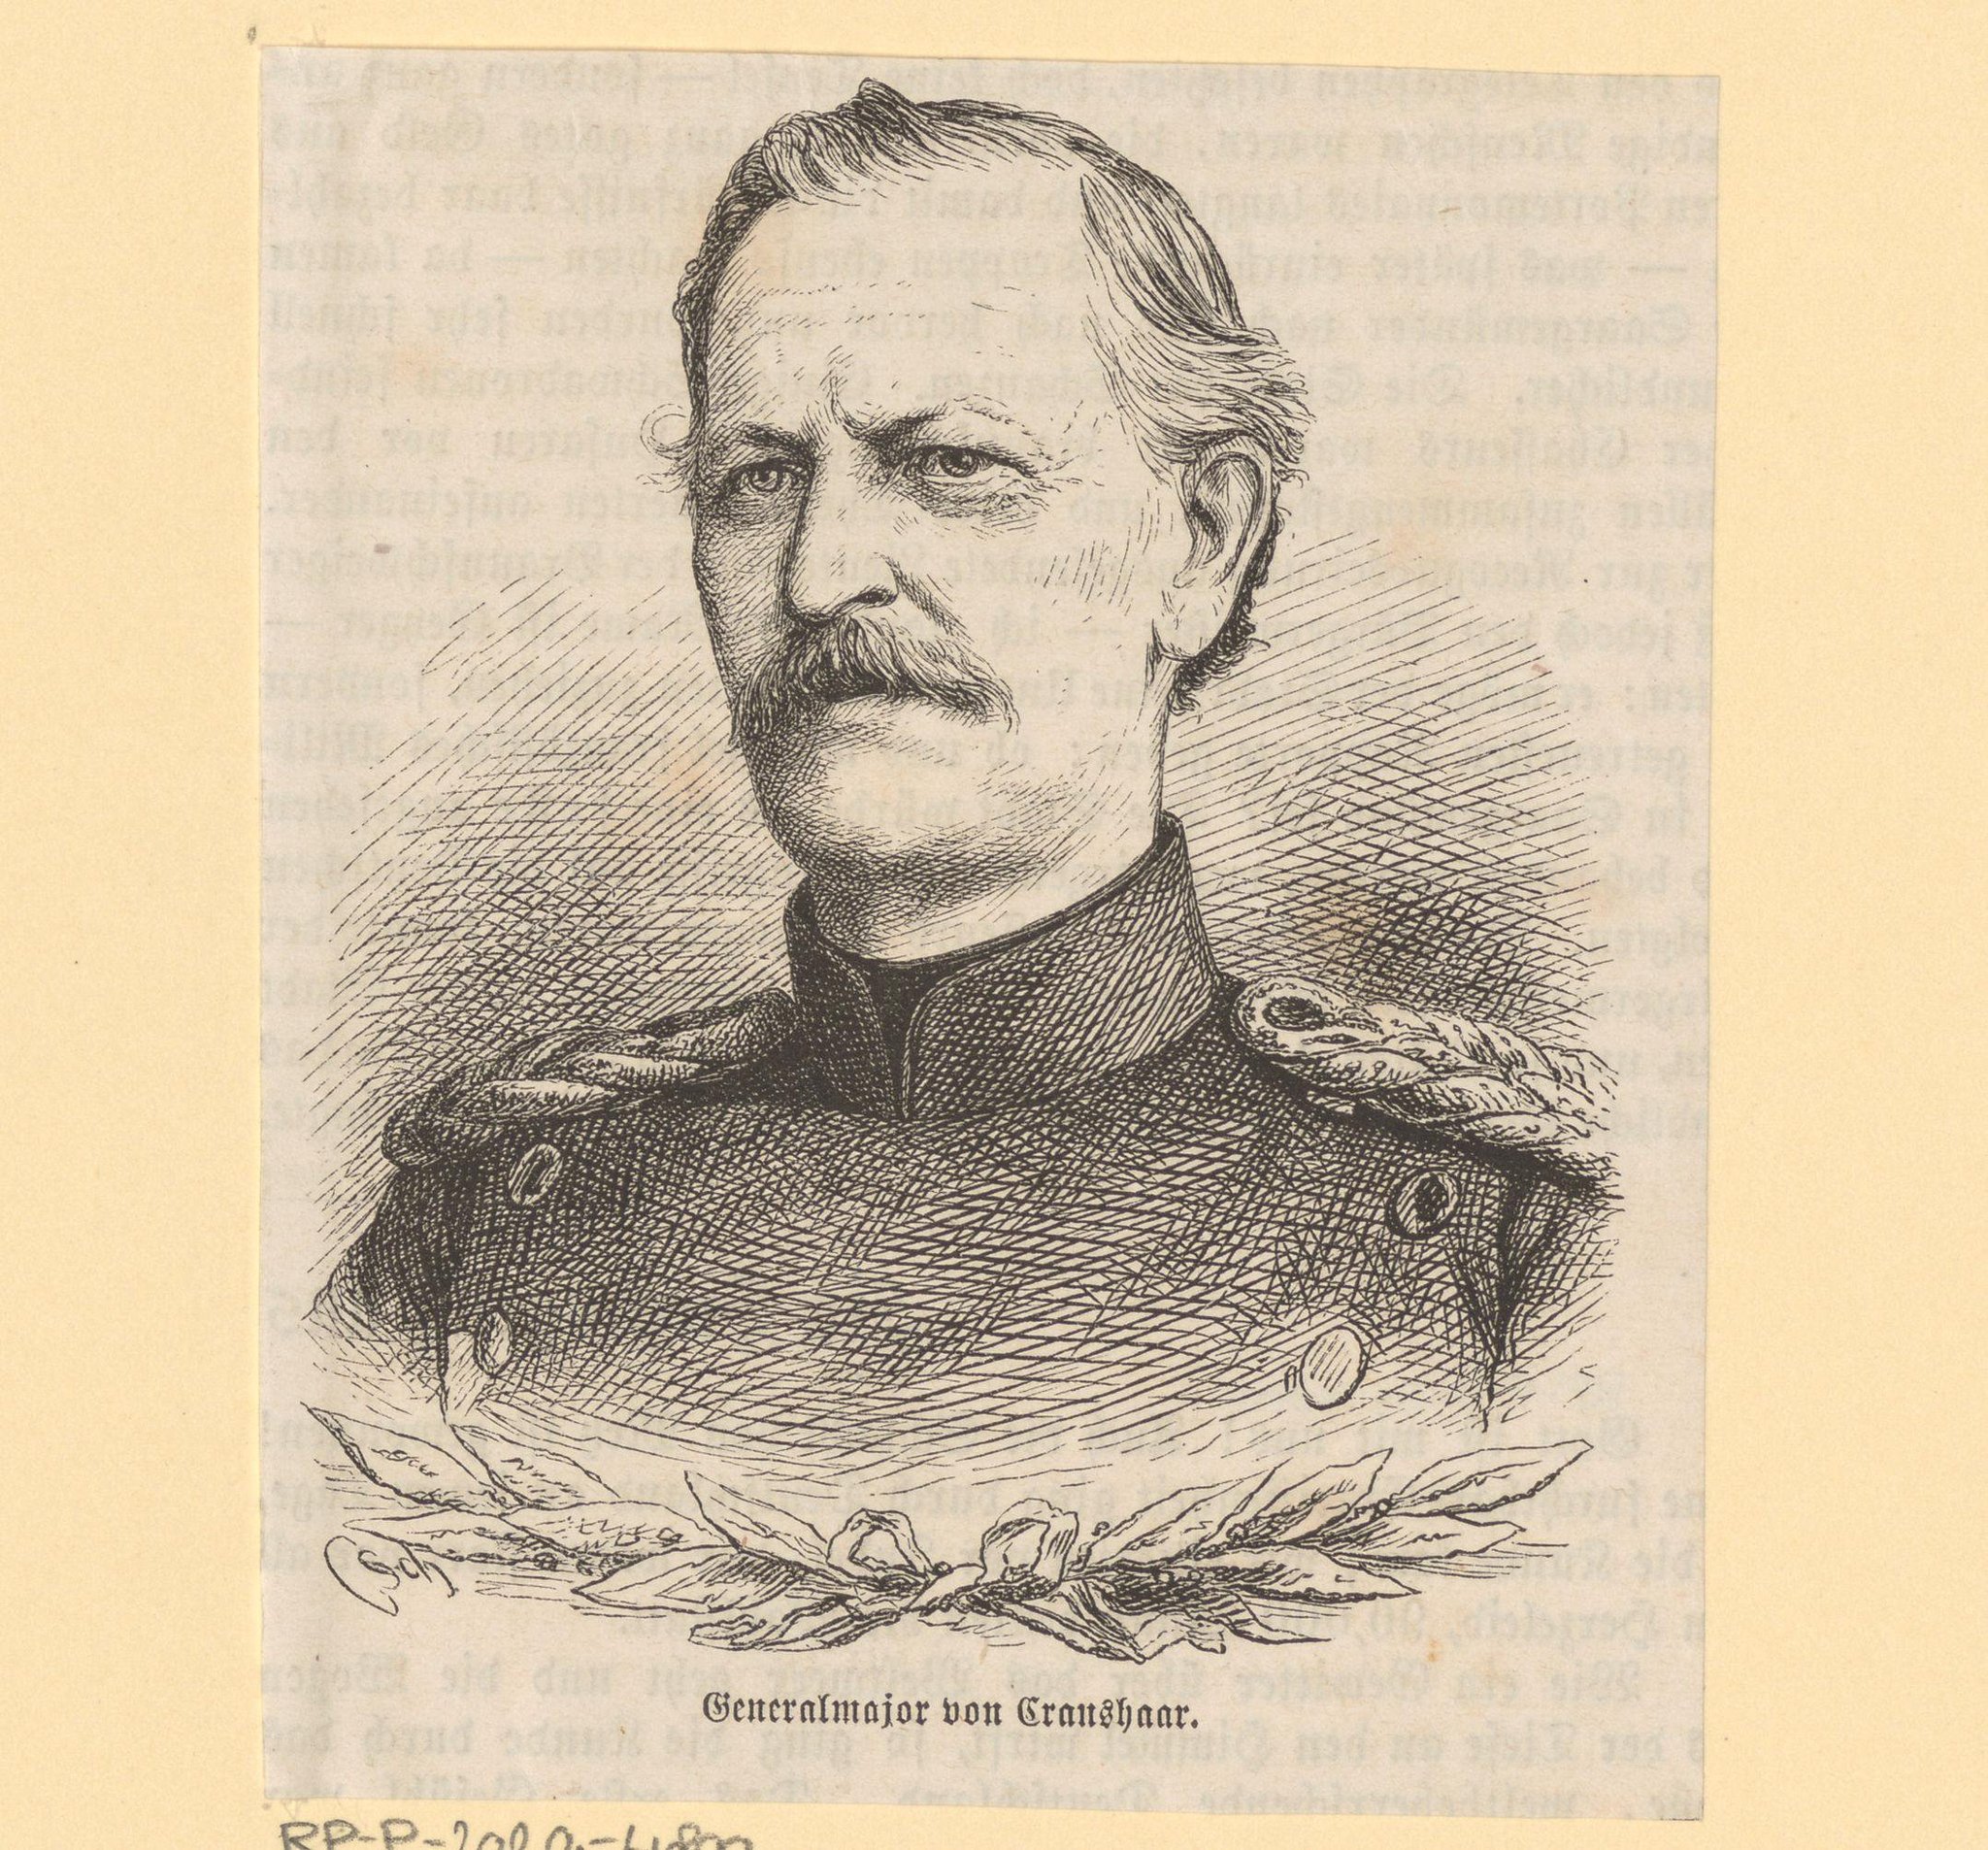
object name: photomechanical print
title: Portret van Ernst von Craushaar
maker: Anonymous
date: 1871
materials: paper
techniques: letterpress printing, printing block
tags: historical persons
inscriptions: collector's mark: ‘JVB’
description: Prent zonder tekst op verso gebruikt in: Brockett, Linus Pierpont. Jahr der schlachten: geschichte des Franzosisch-deutschen krieges von 1870 (...). New York: H.S. Goodspeed & Co., 1871.